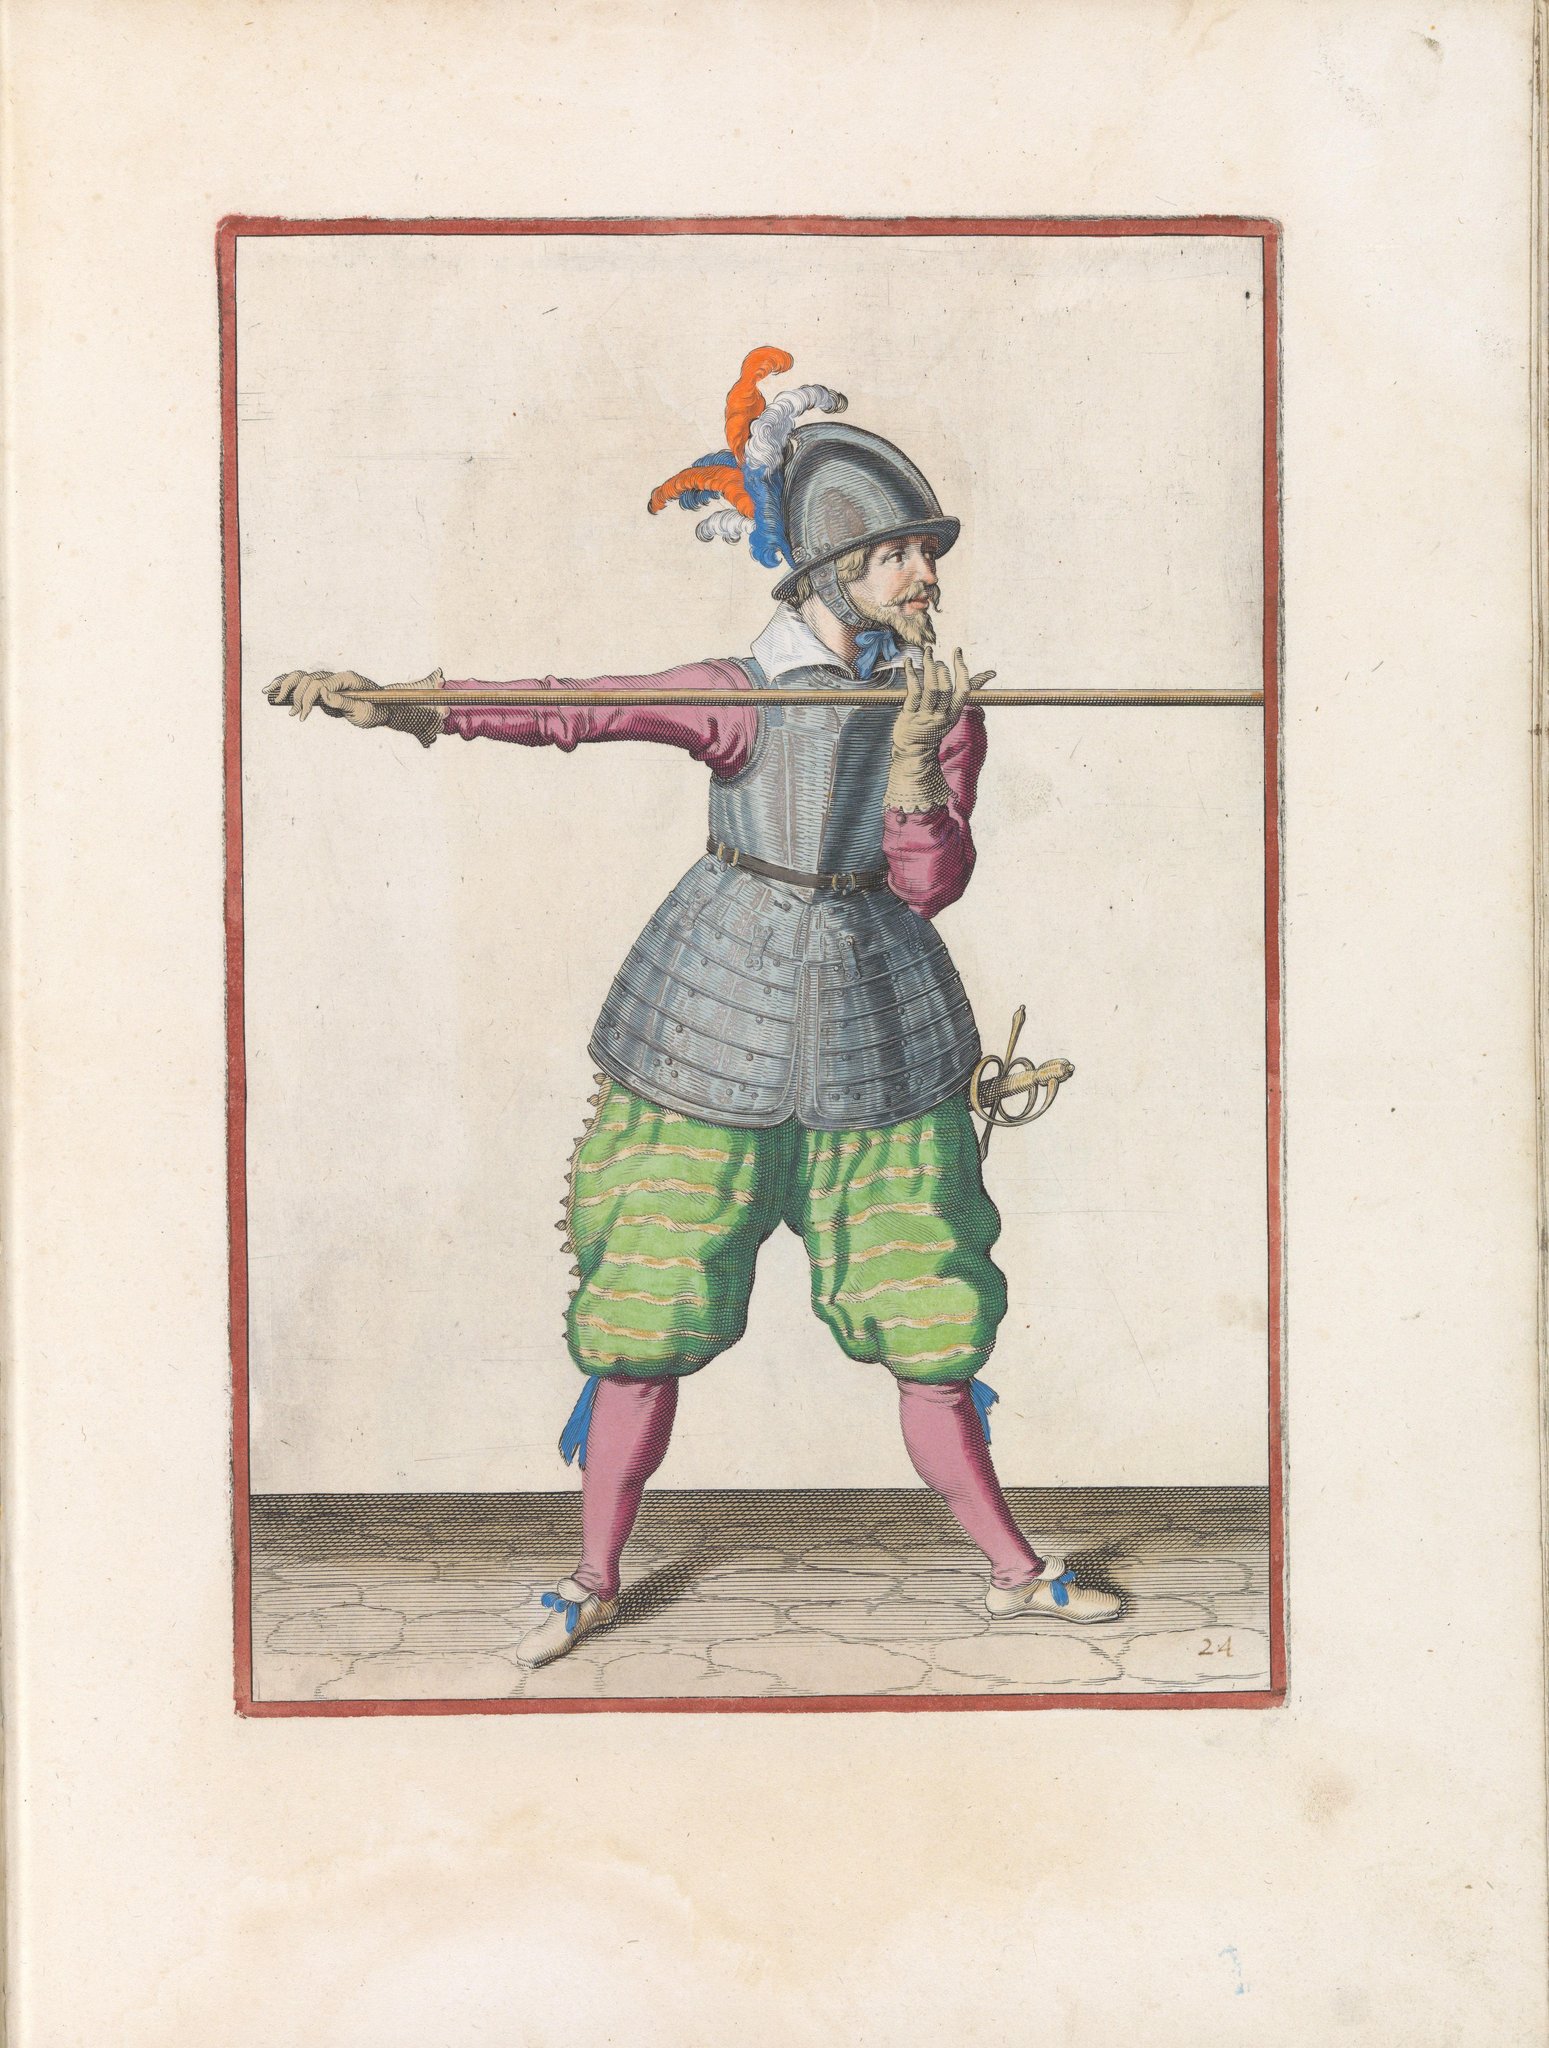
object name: print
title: Soldaat die zijn spies met beide handen horizontaal op schouderhoogte draagt, zijn rechterhand bij de voet van het wapen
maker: jacques de gheyn (ii)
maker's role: painter, print maker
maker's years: 1565-1629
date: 1597-1607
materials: paper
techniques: engraving, hand coloring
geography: the hague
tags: handling of weapons ~ military training, helved weapons, polearms (for striking, hacking, thrusting): lance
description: Een soldaat, ten voeten uit, die een spies (lans) met beide handen horizontaal op schouderhoogte draagt, zijn rechterhand bij de voet van het wapen. Deze prent is onderdeel van de reeks van 32 met de hand genummerde prenten van spiesdragers in de Wapenhandelinghe.